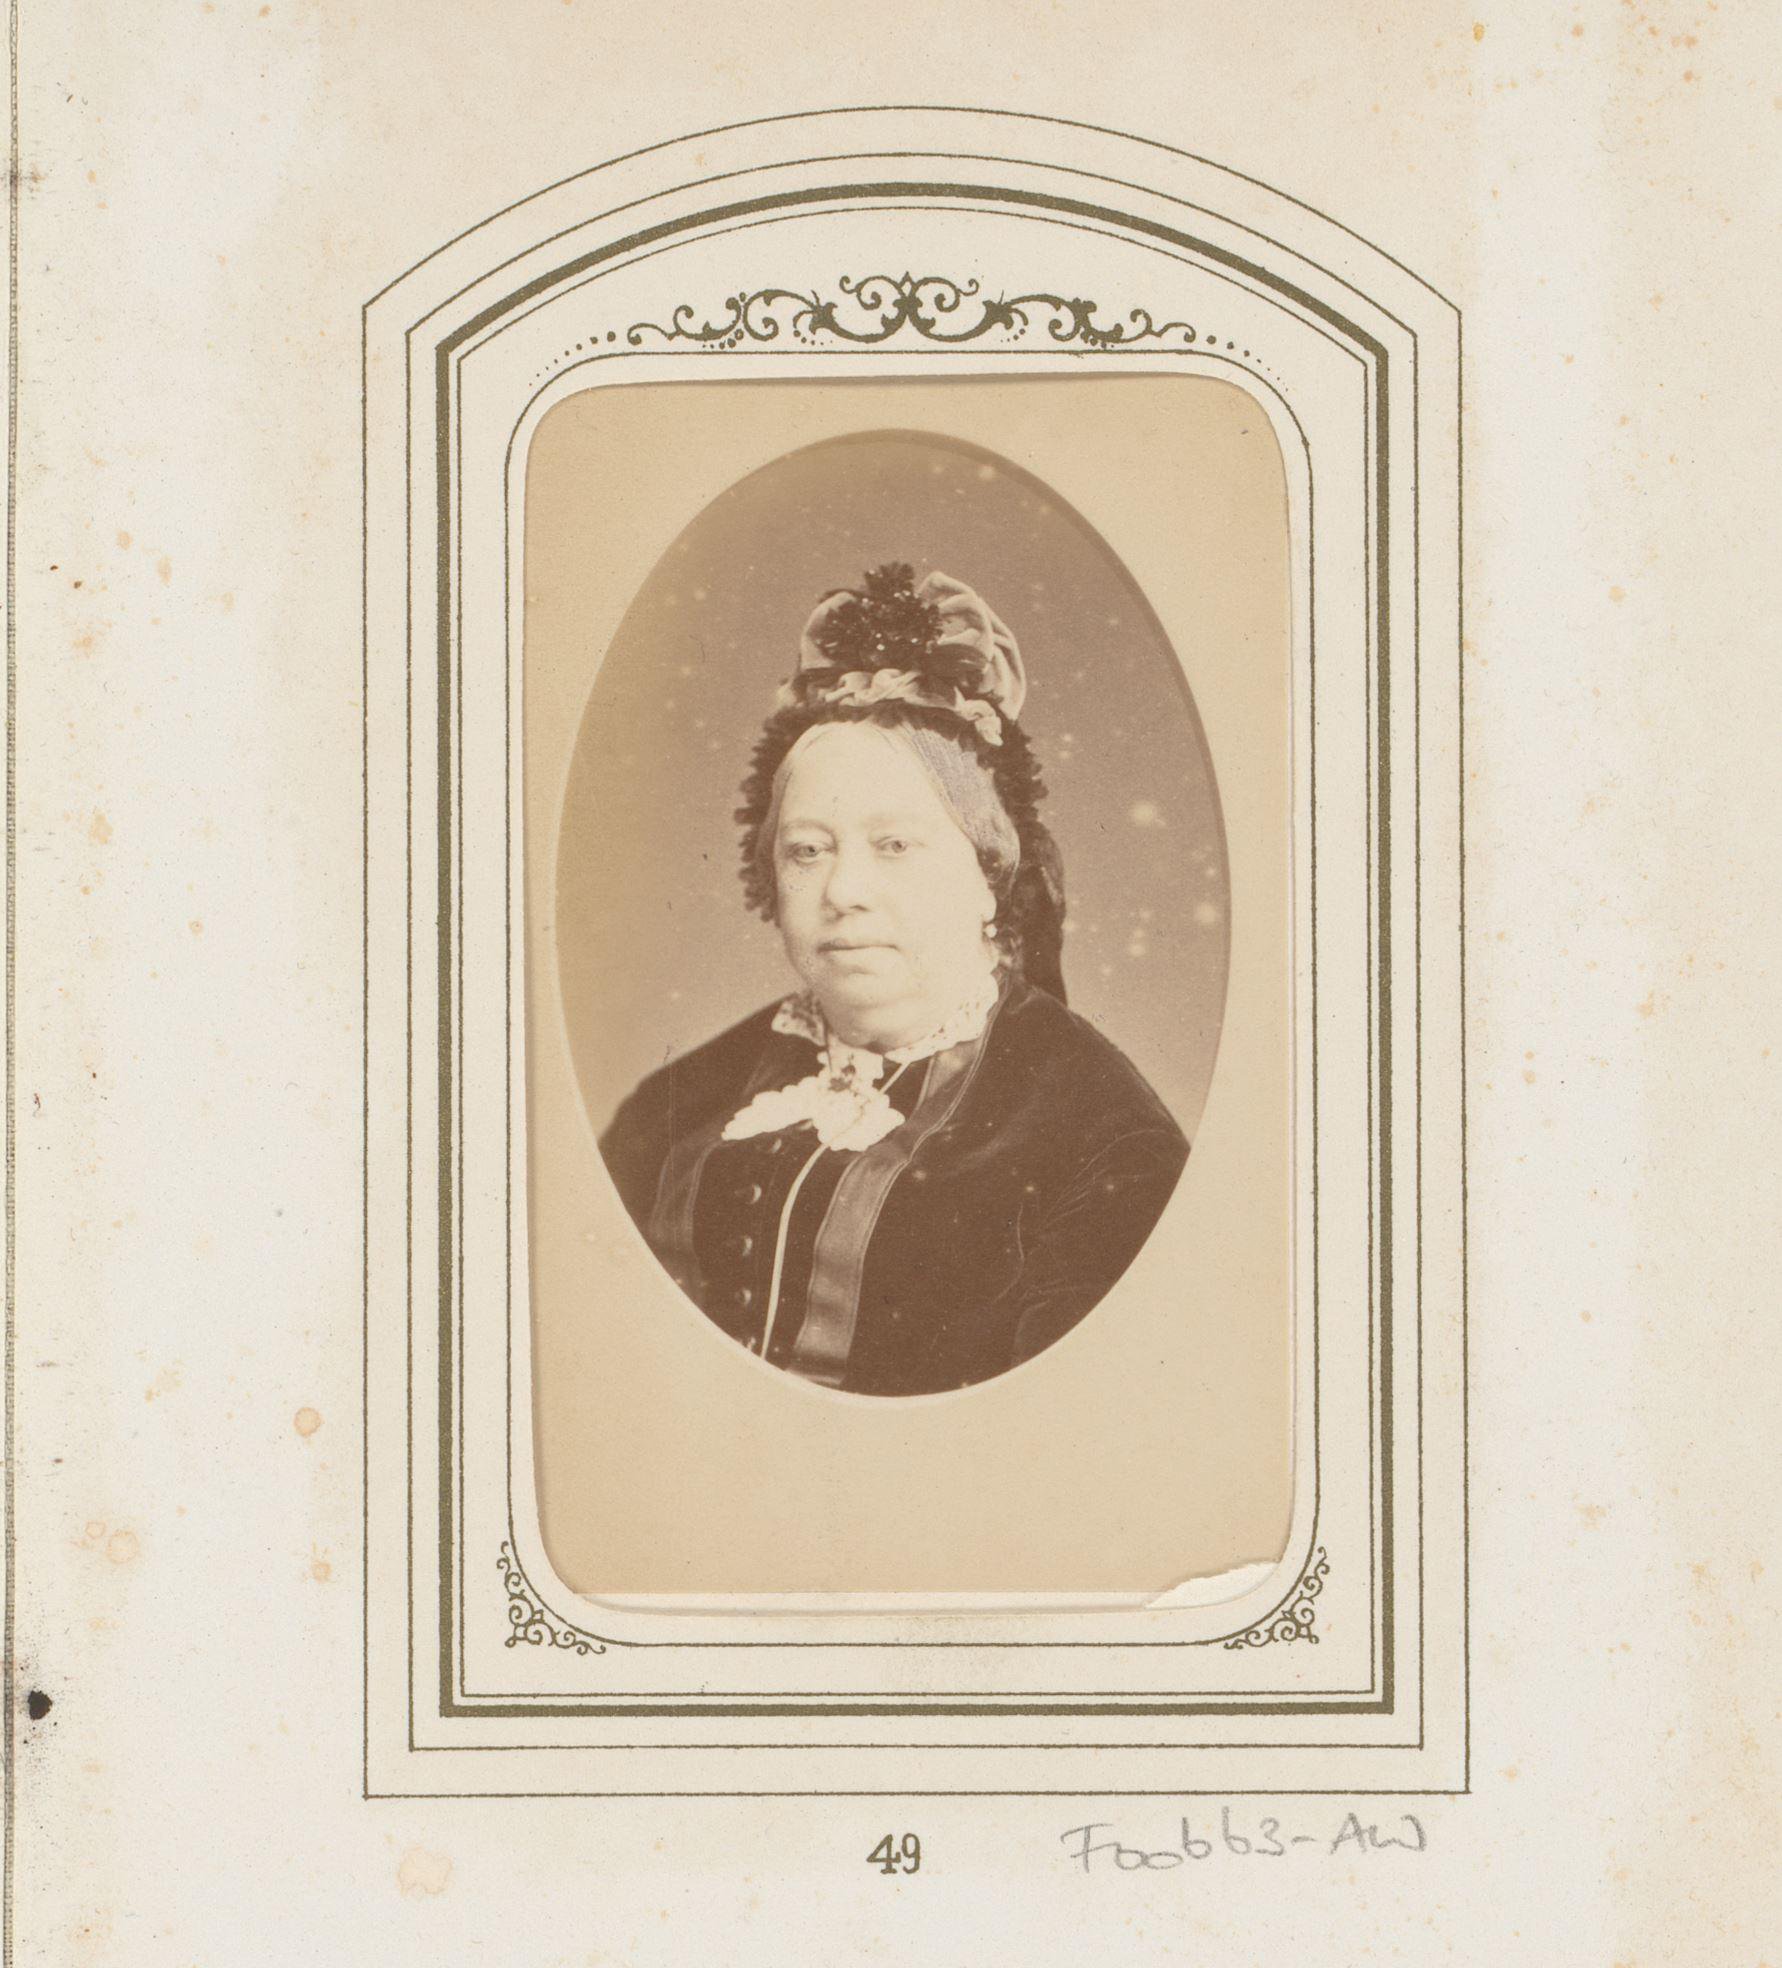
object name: carte de visite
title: Portret van een vrouw met muts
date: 1860-1870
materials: cardboard, photographic support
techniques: albumen print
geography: brussels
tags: historical persons - bb - woman, head-gear: cap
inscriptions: number: ‘49’, inscription: ‘Ghémar Frères/ Photographes/ de S.M. le Roi des Belges/ Bruxelles/ 27, rue de l'écuyer, 27’